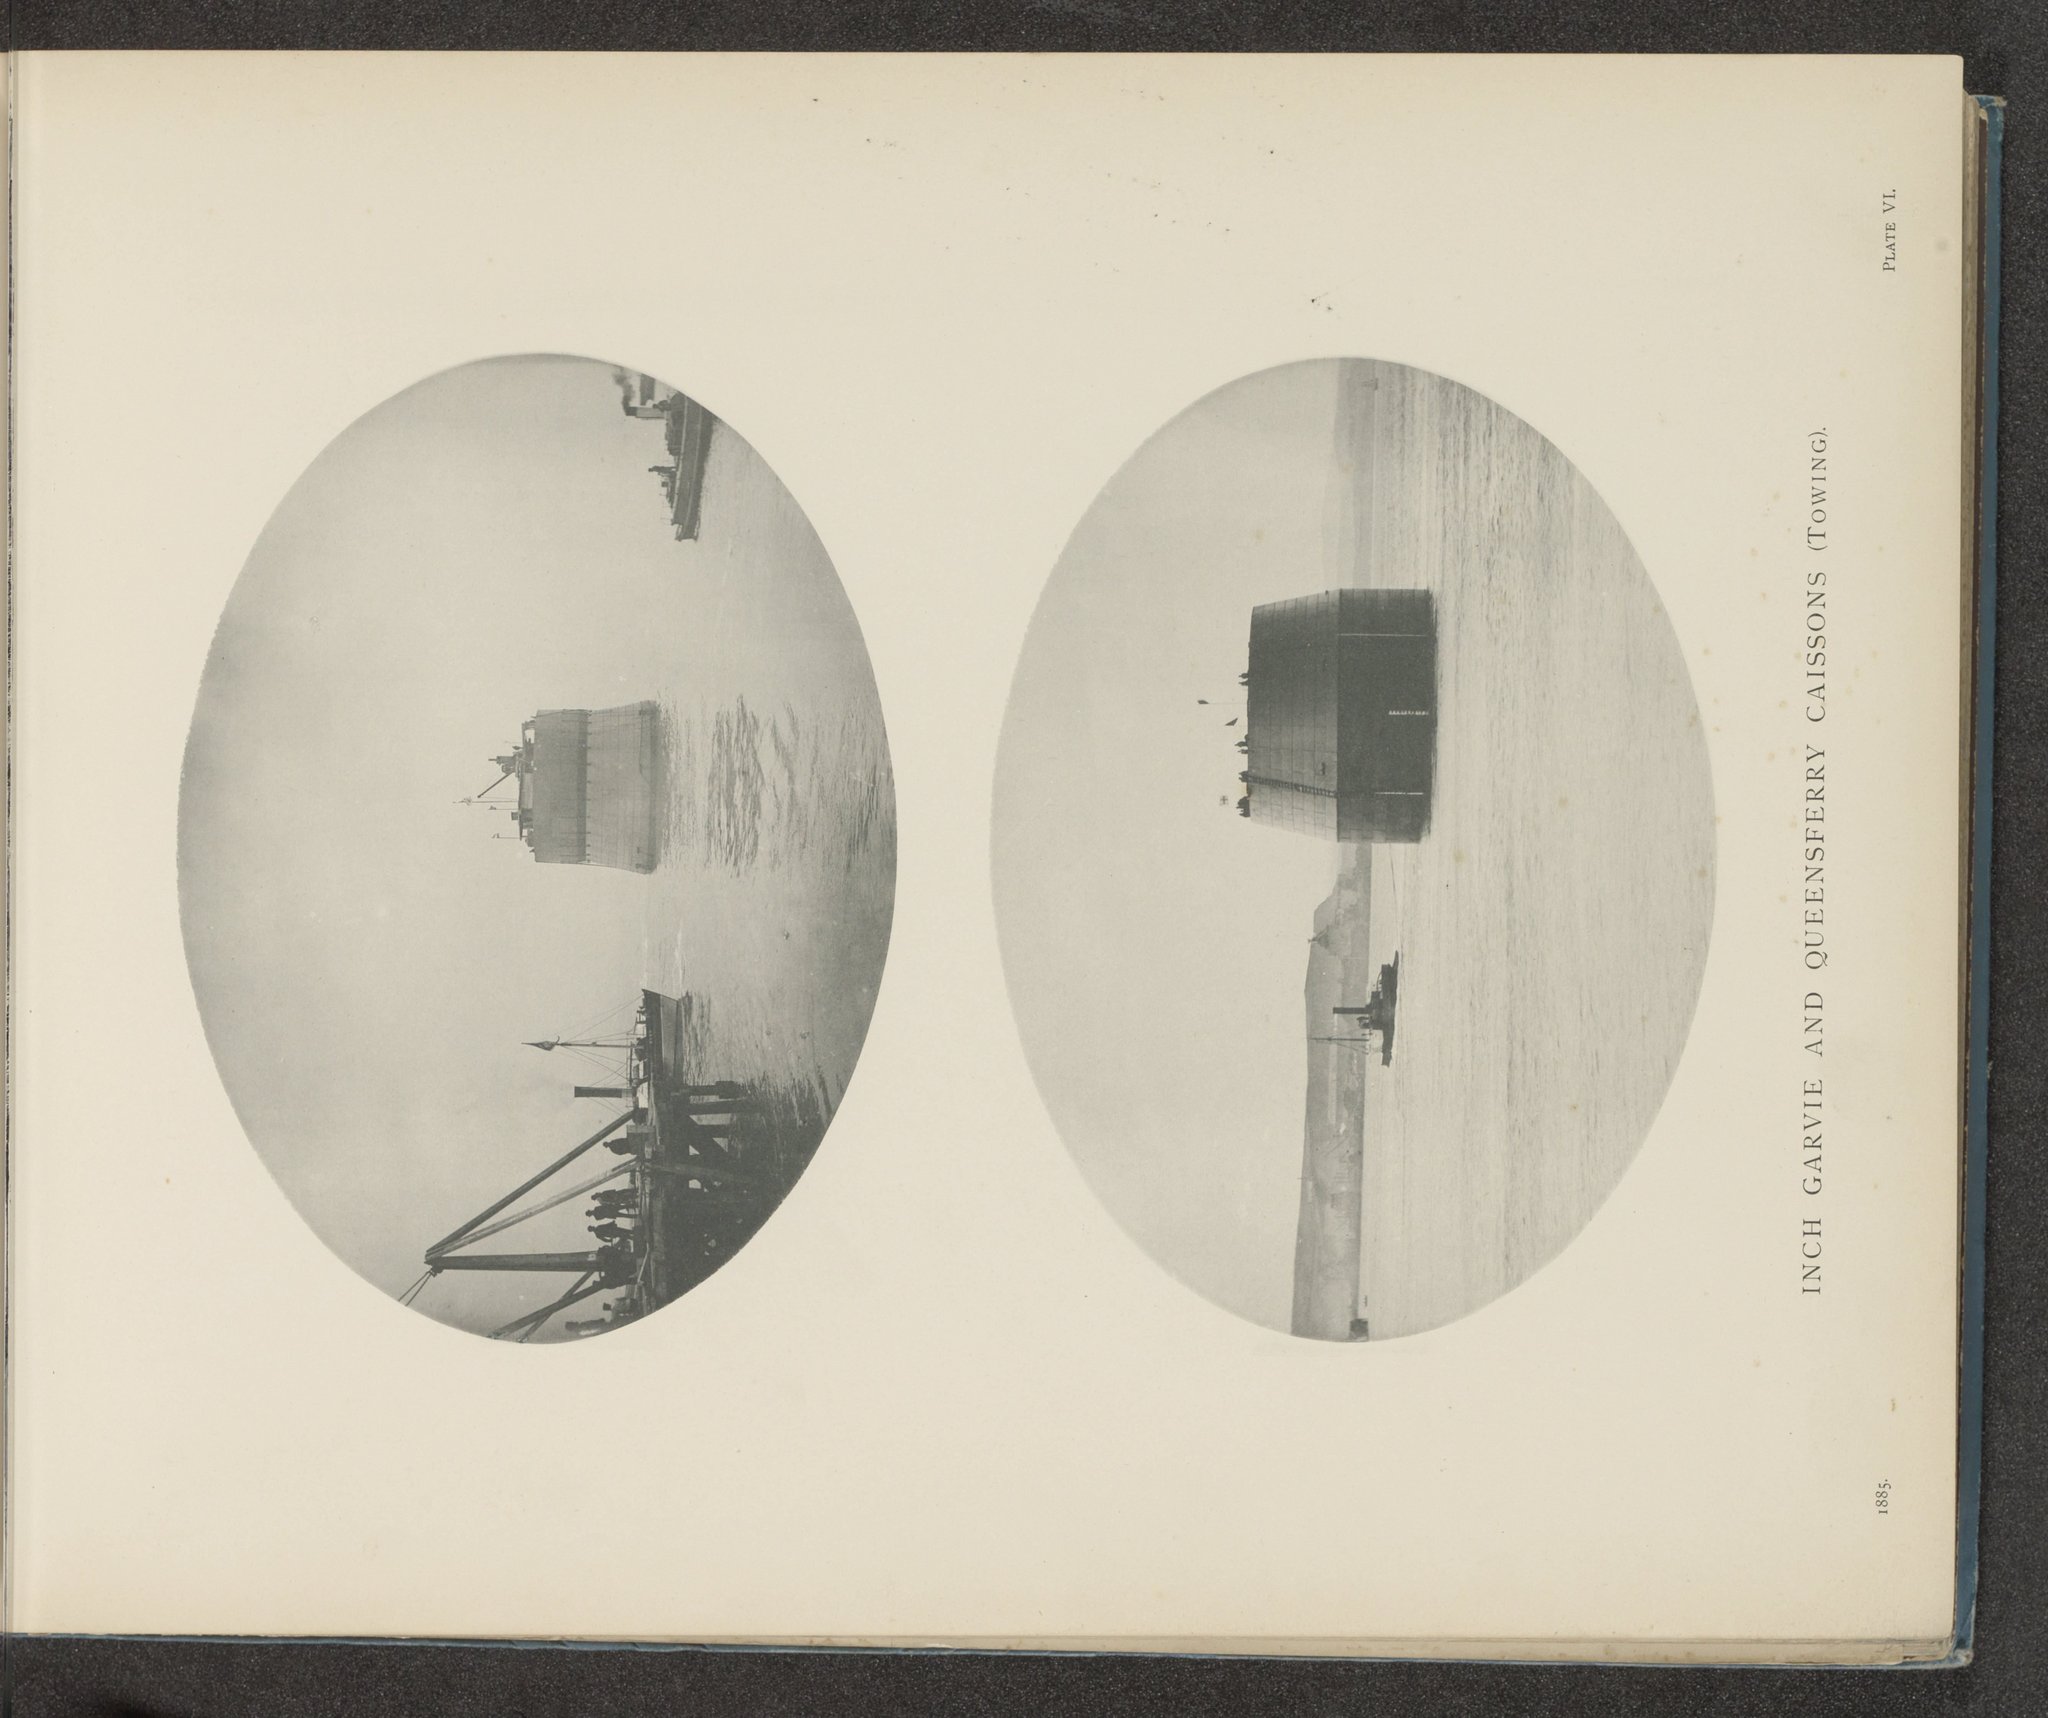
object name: page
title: Inch Garvie and Queensferry caissons (towing)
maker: Anonymous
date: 1885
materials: paper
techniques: photograph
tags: river, tow-boat, towing-barge, building-site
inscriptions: number: ‘Plate VI.’